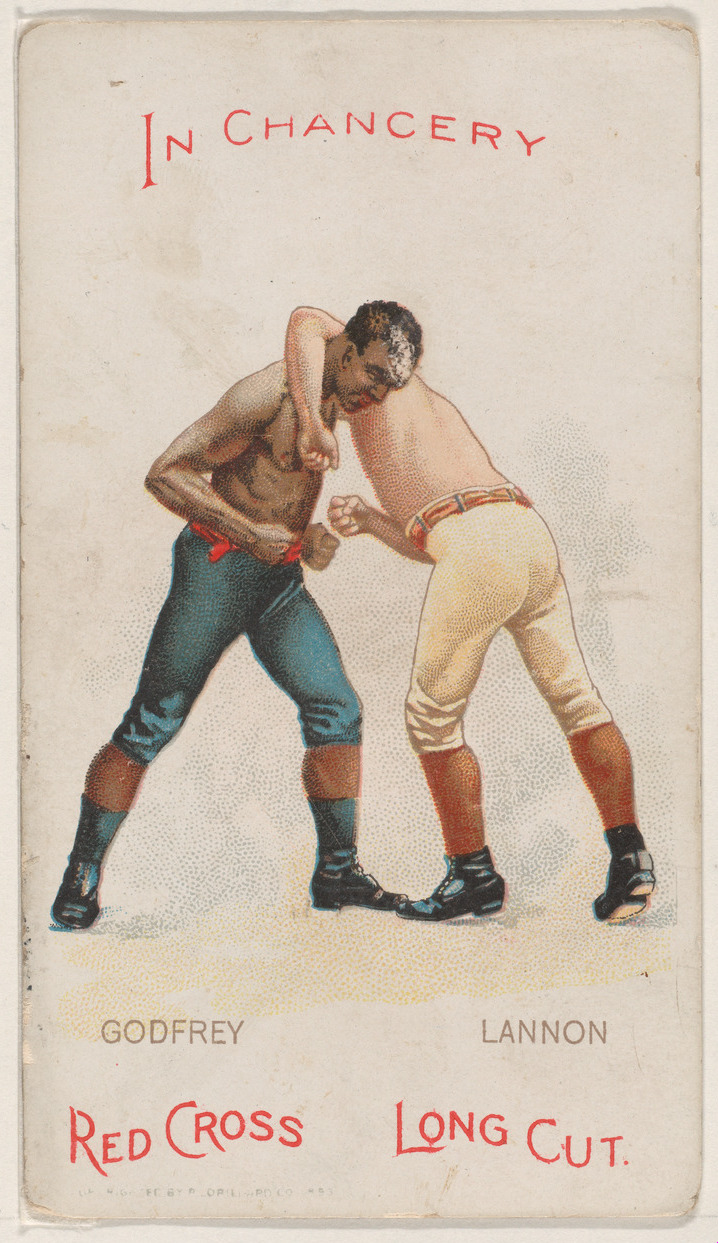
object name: print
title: In Chancery, George Godfrey and Joe Lannon, from the Boxing Positions and Boxers series (N266) issued by P. Lorillard Company to promote Red Cross Long Cut Tobacco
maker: p. lorillard company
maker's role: publisher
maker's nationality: american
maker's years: 1760-2014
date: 1893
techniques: color lithograph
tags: men,boxing,athletes